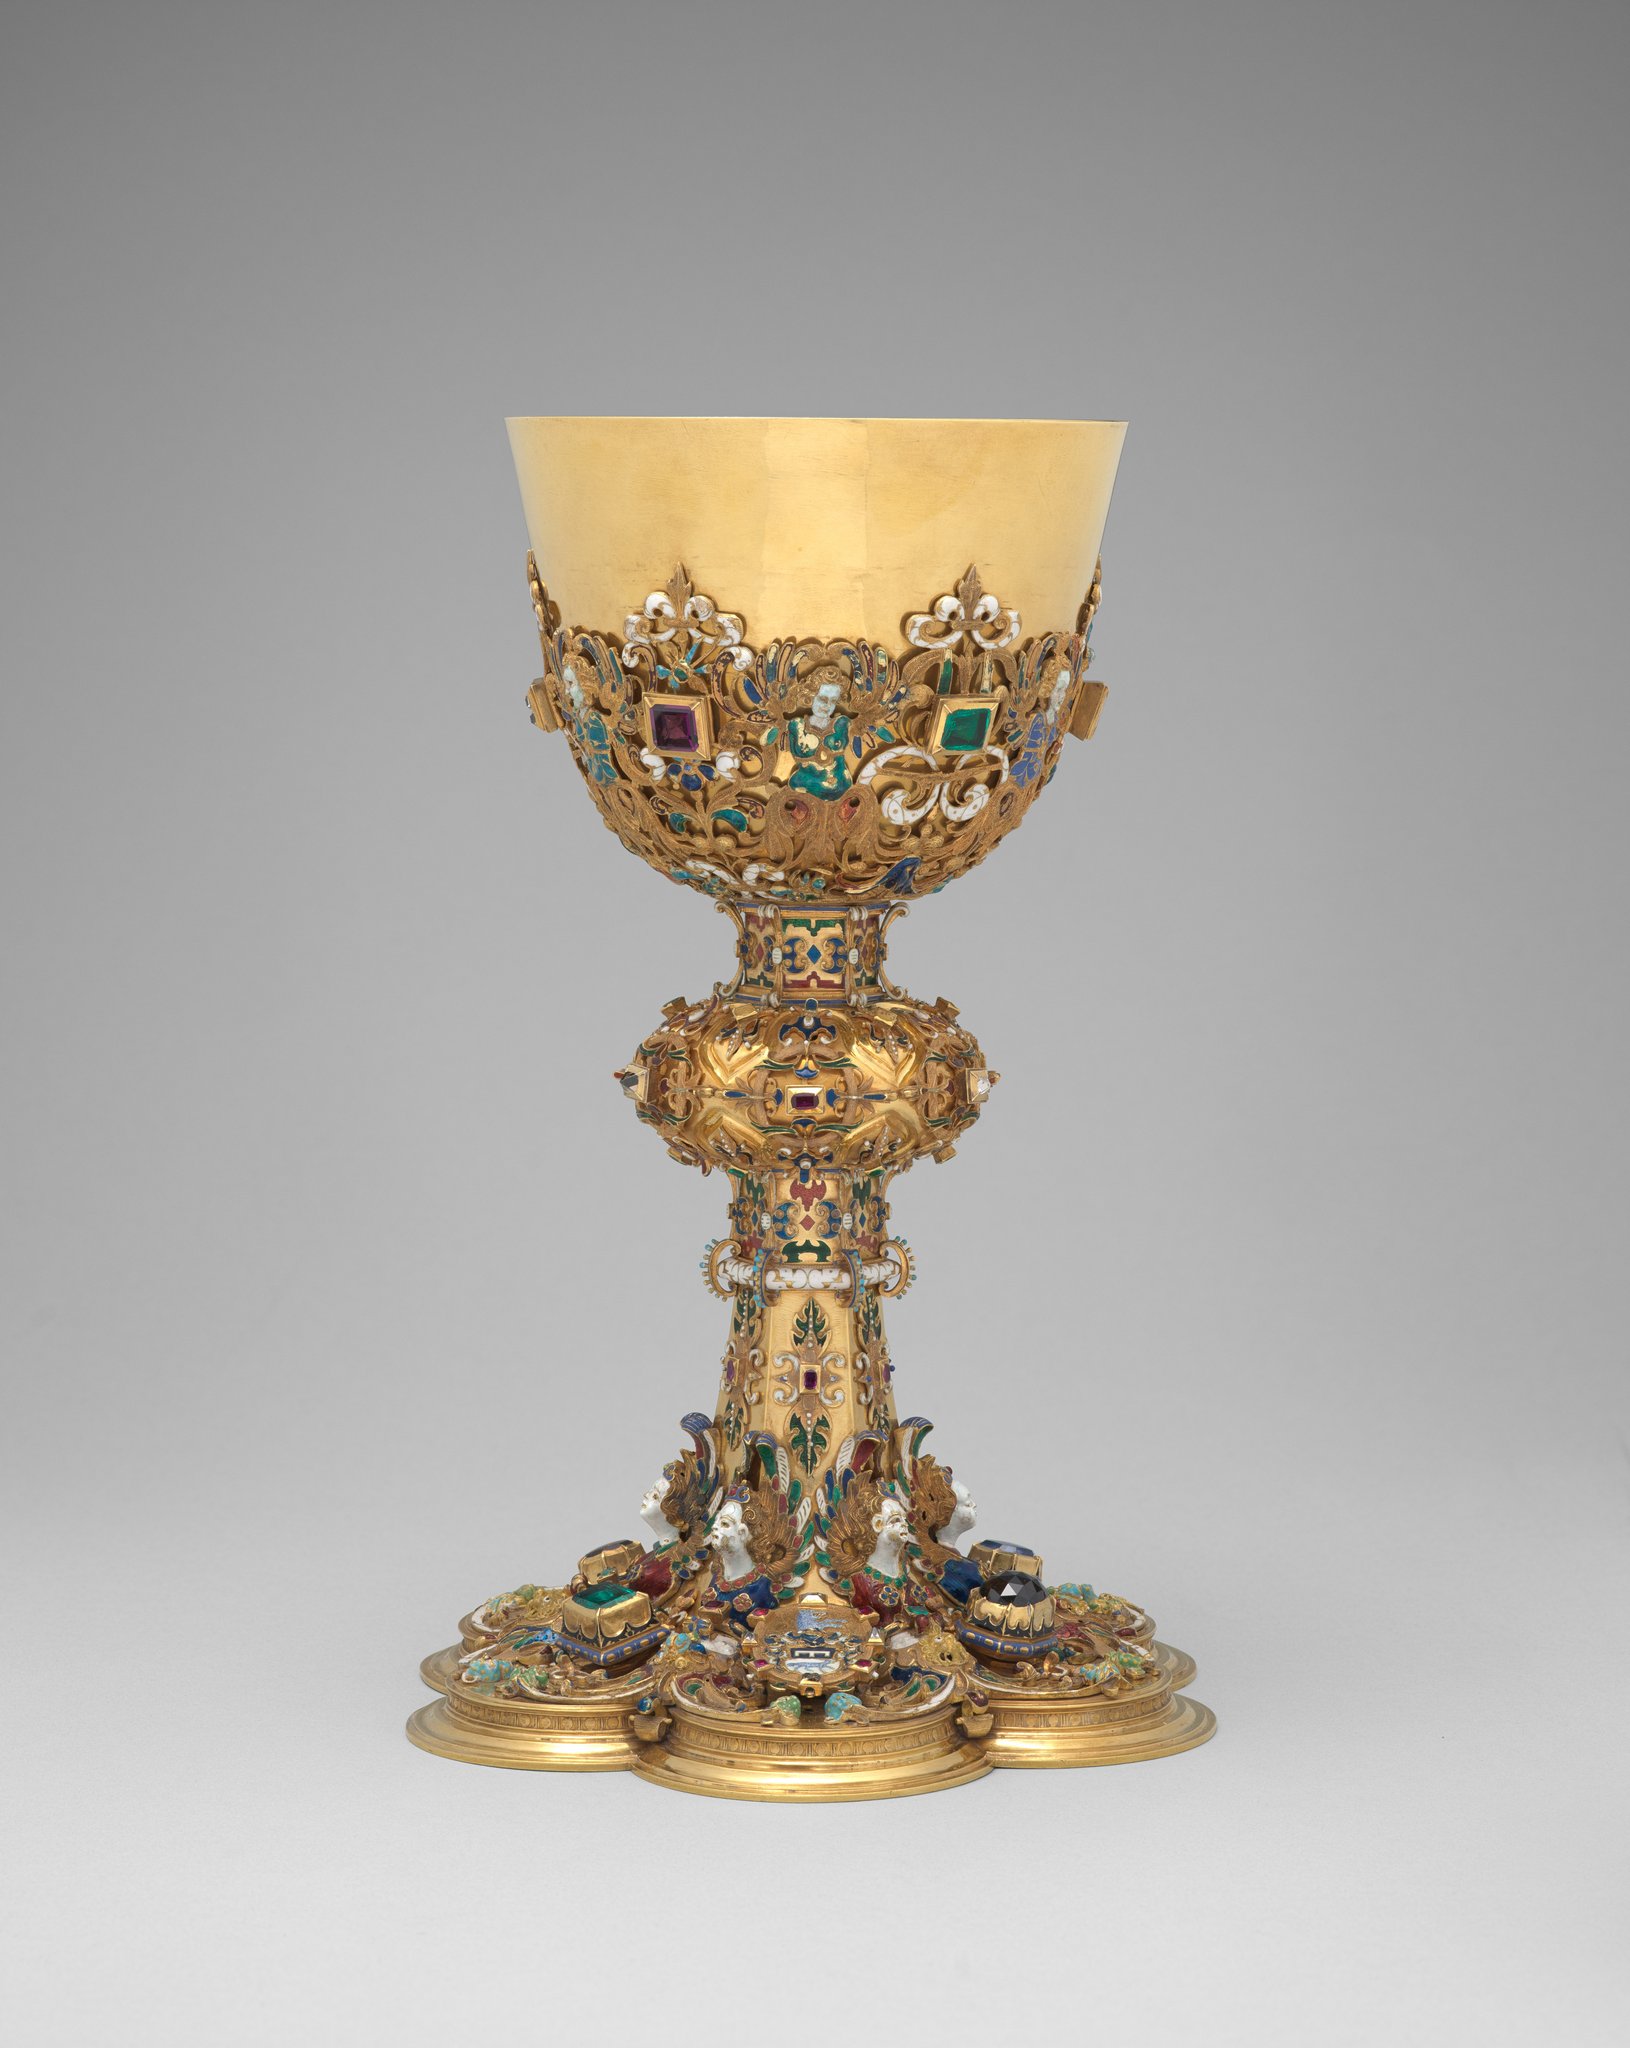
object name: chalice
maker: otto meier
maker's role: maker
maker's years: 1604-1621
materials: enamel, gold